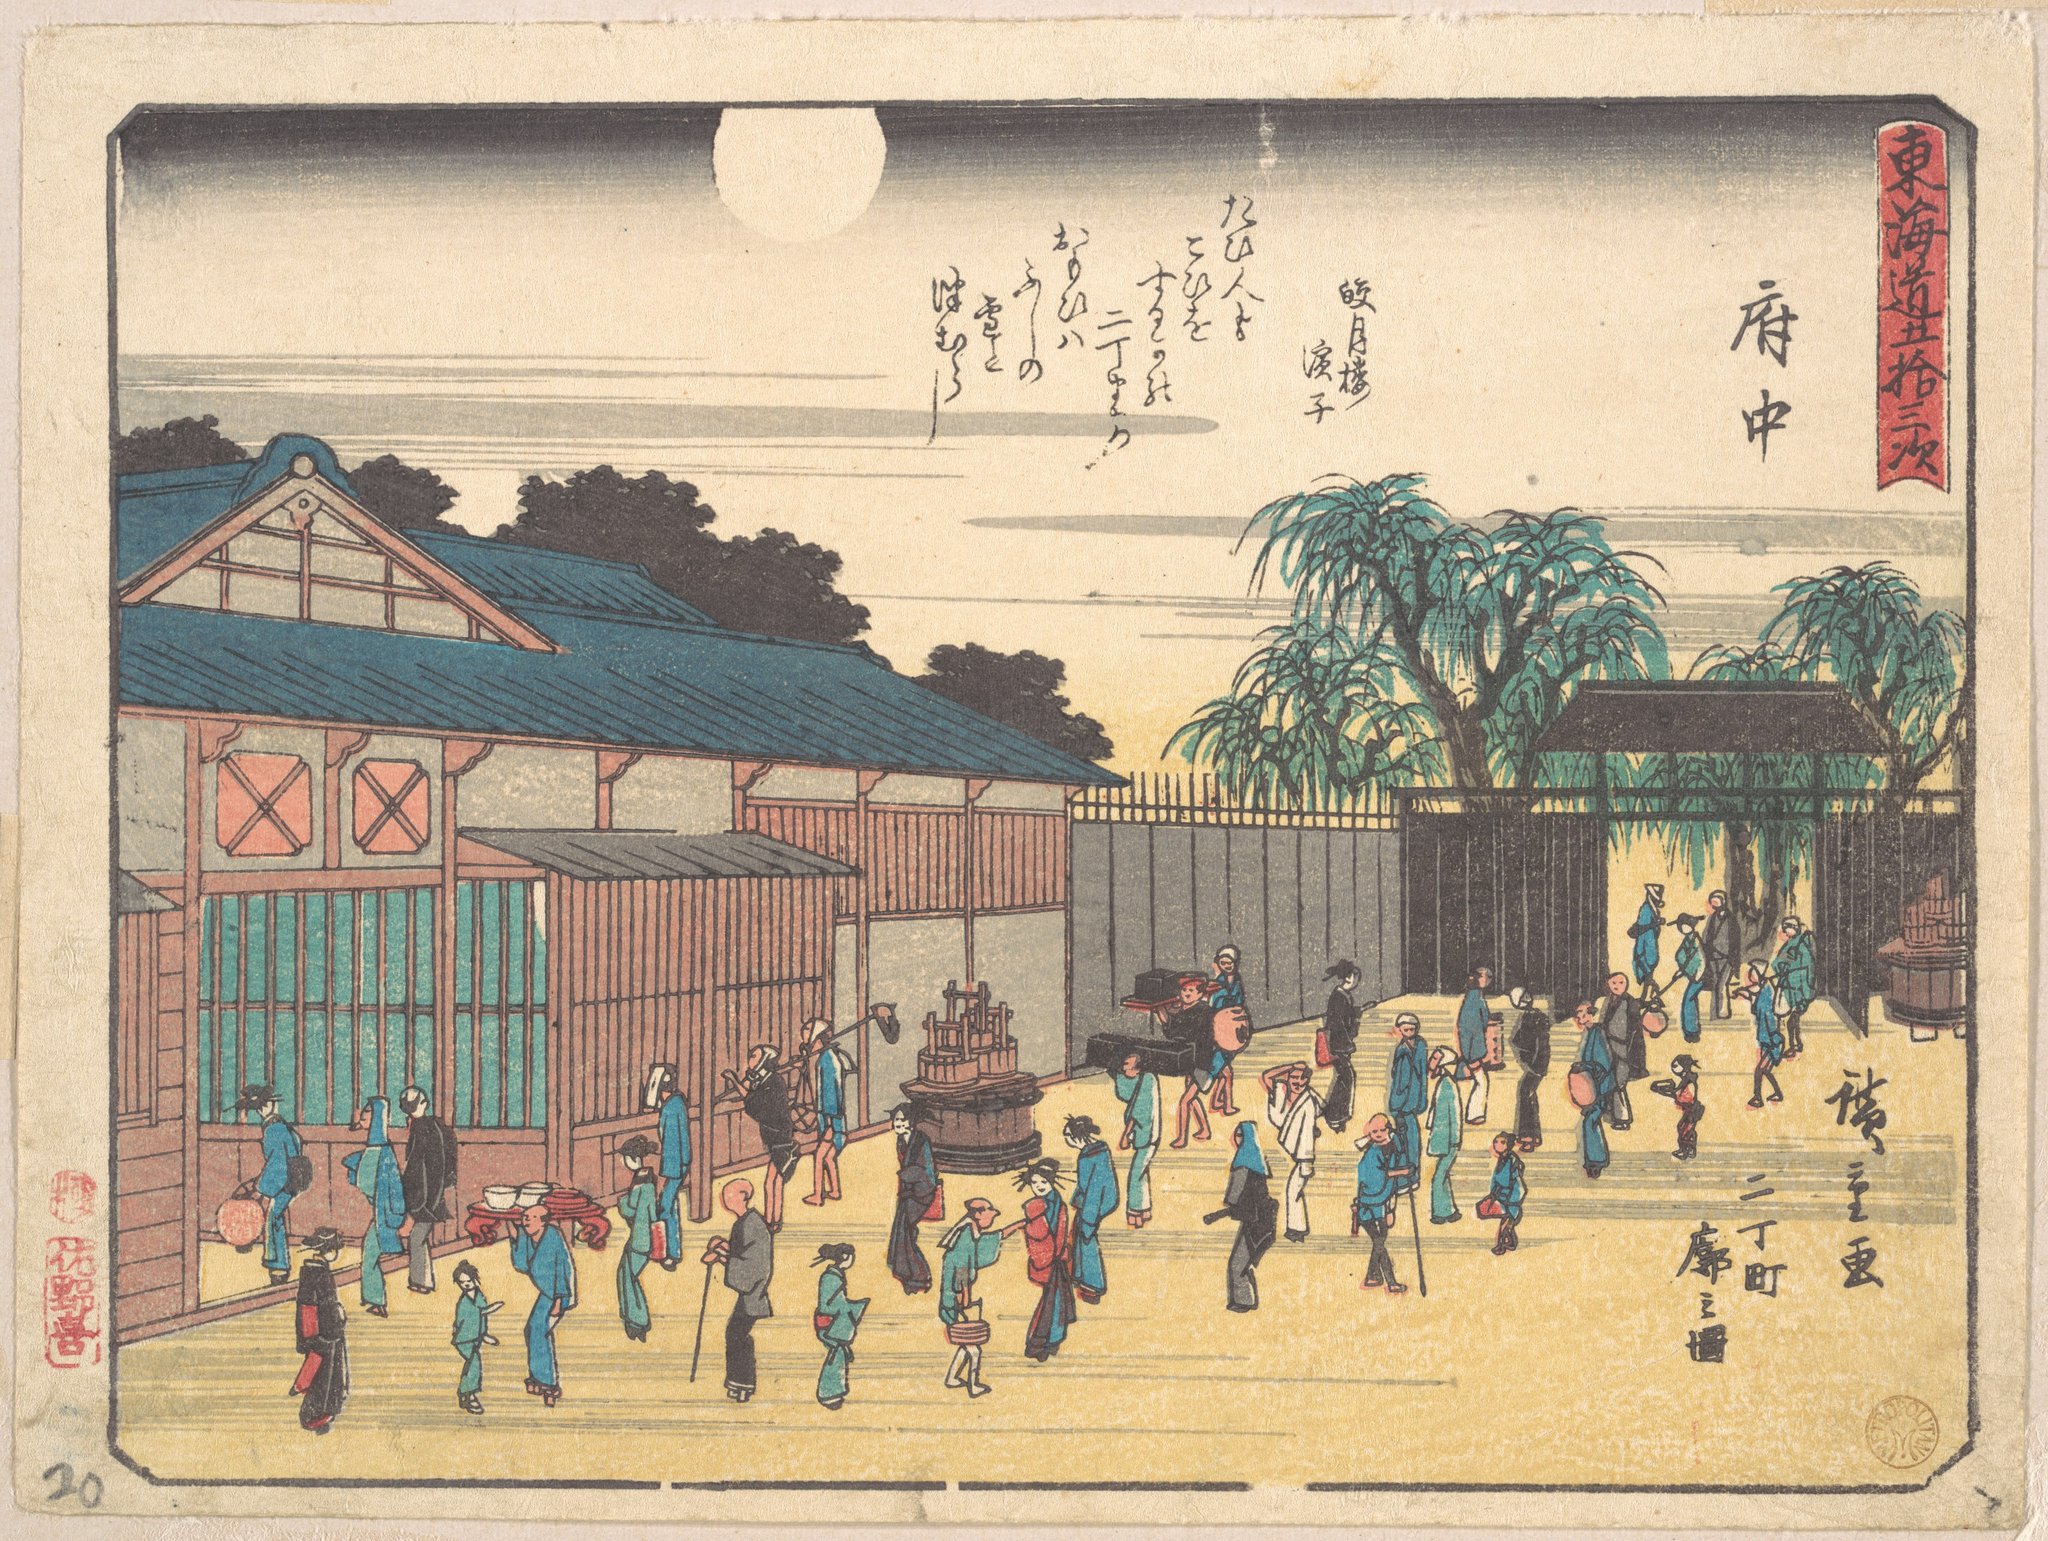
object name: print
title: Fuchu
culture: japanese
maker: utagawa hiroshige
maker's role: artist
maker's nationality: japanese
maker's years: 1797-1858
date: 1838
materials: ink, paper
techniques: woodblock print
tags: gates,men,women,street scene